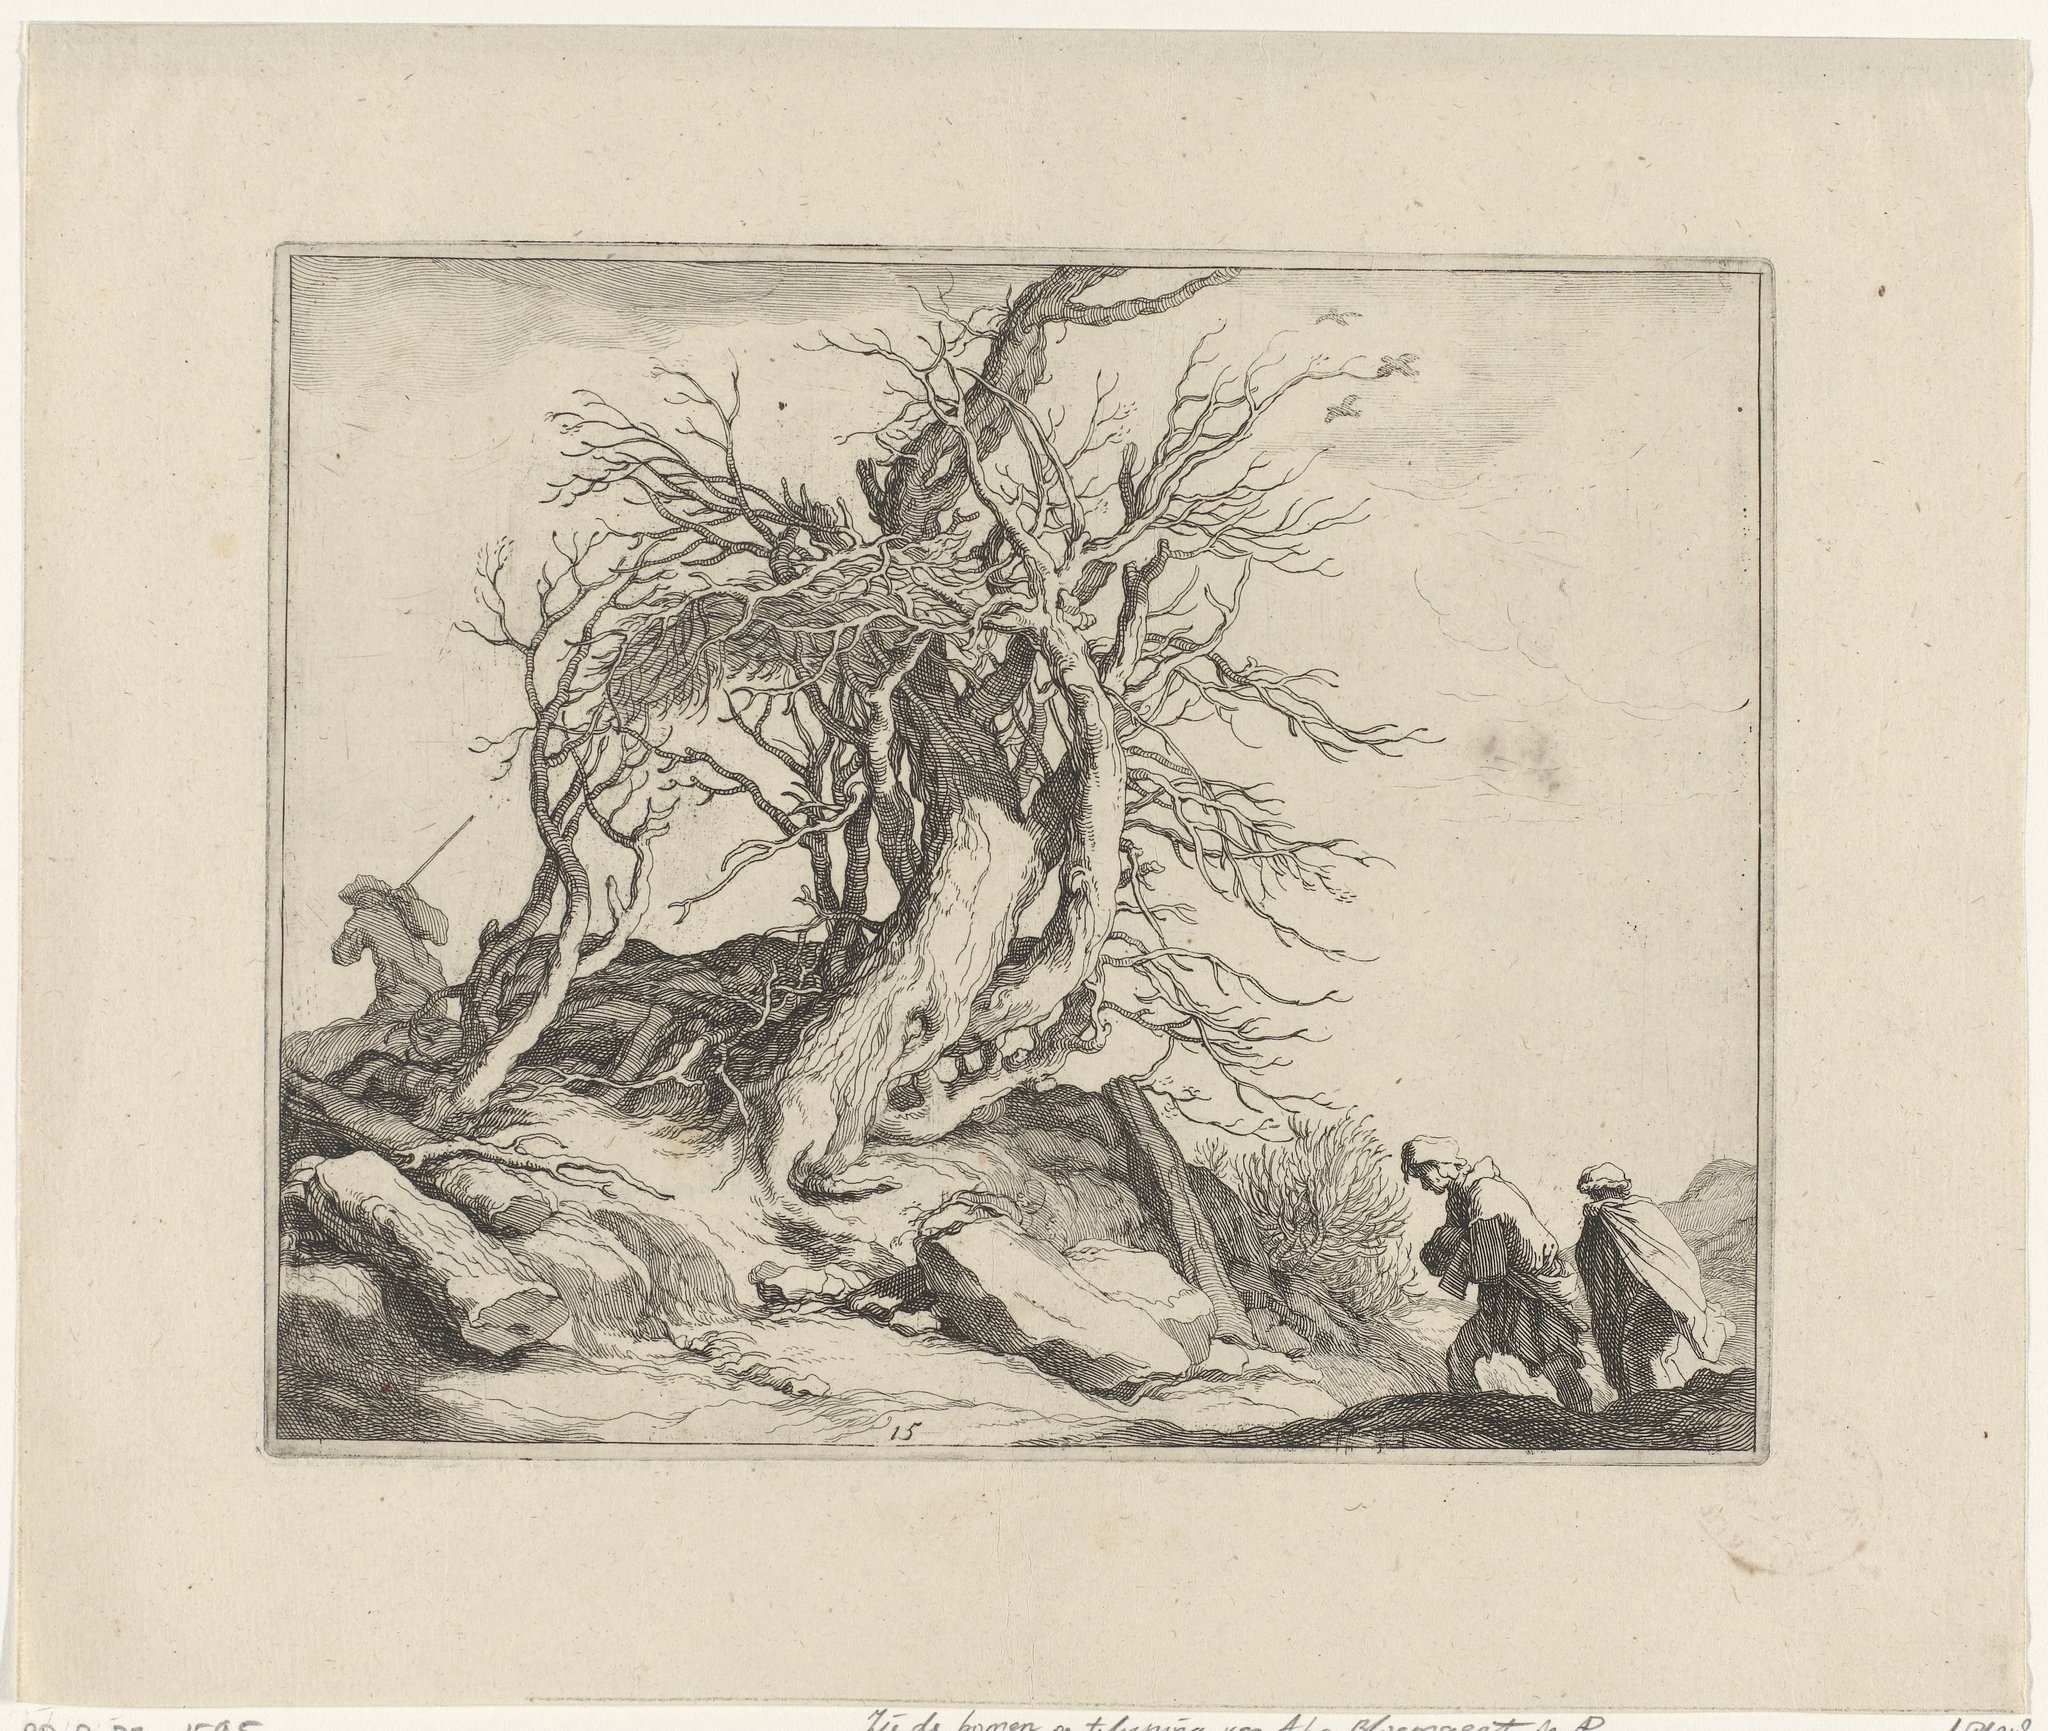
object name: print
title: Zicht op een kale boom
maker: frederick bloemaert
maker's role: print maker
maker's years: 1614-1669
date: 1635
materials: paper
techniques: etching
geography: utrecht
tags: trees, landscapes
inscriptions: collector's mark: Lugt 240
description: Een kale, knoestige boom staat in het midden op een heuveltje. Voor de boom liggen enkele boomstammen. Aan weerszijden van de heuvel zijn mannen te zien.